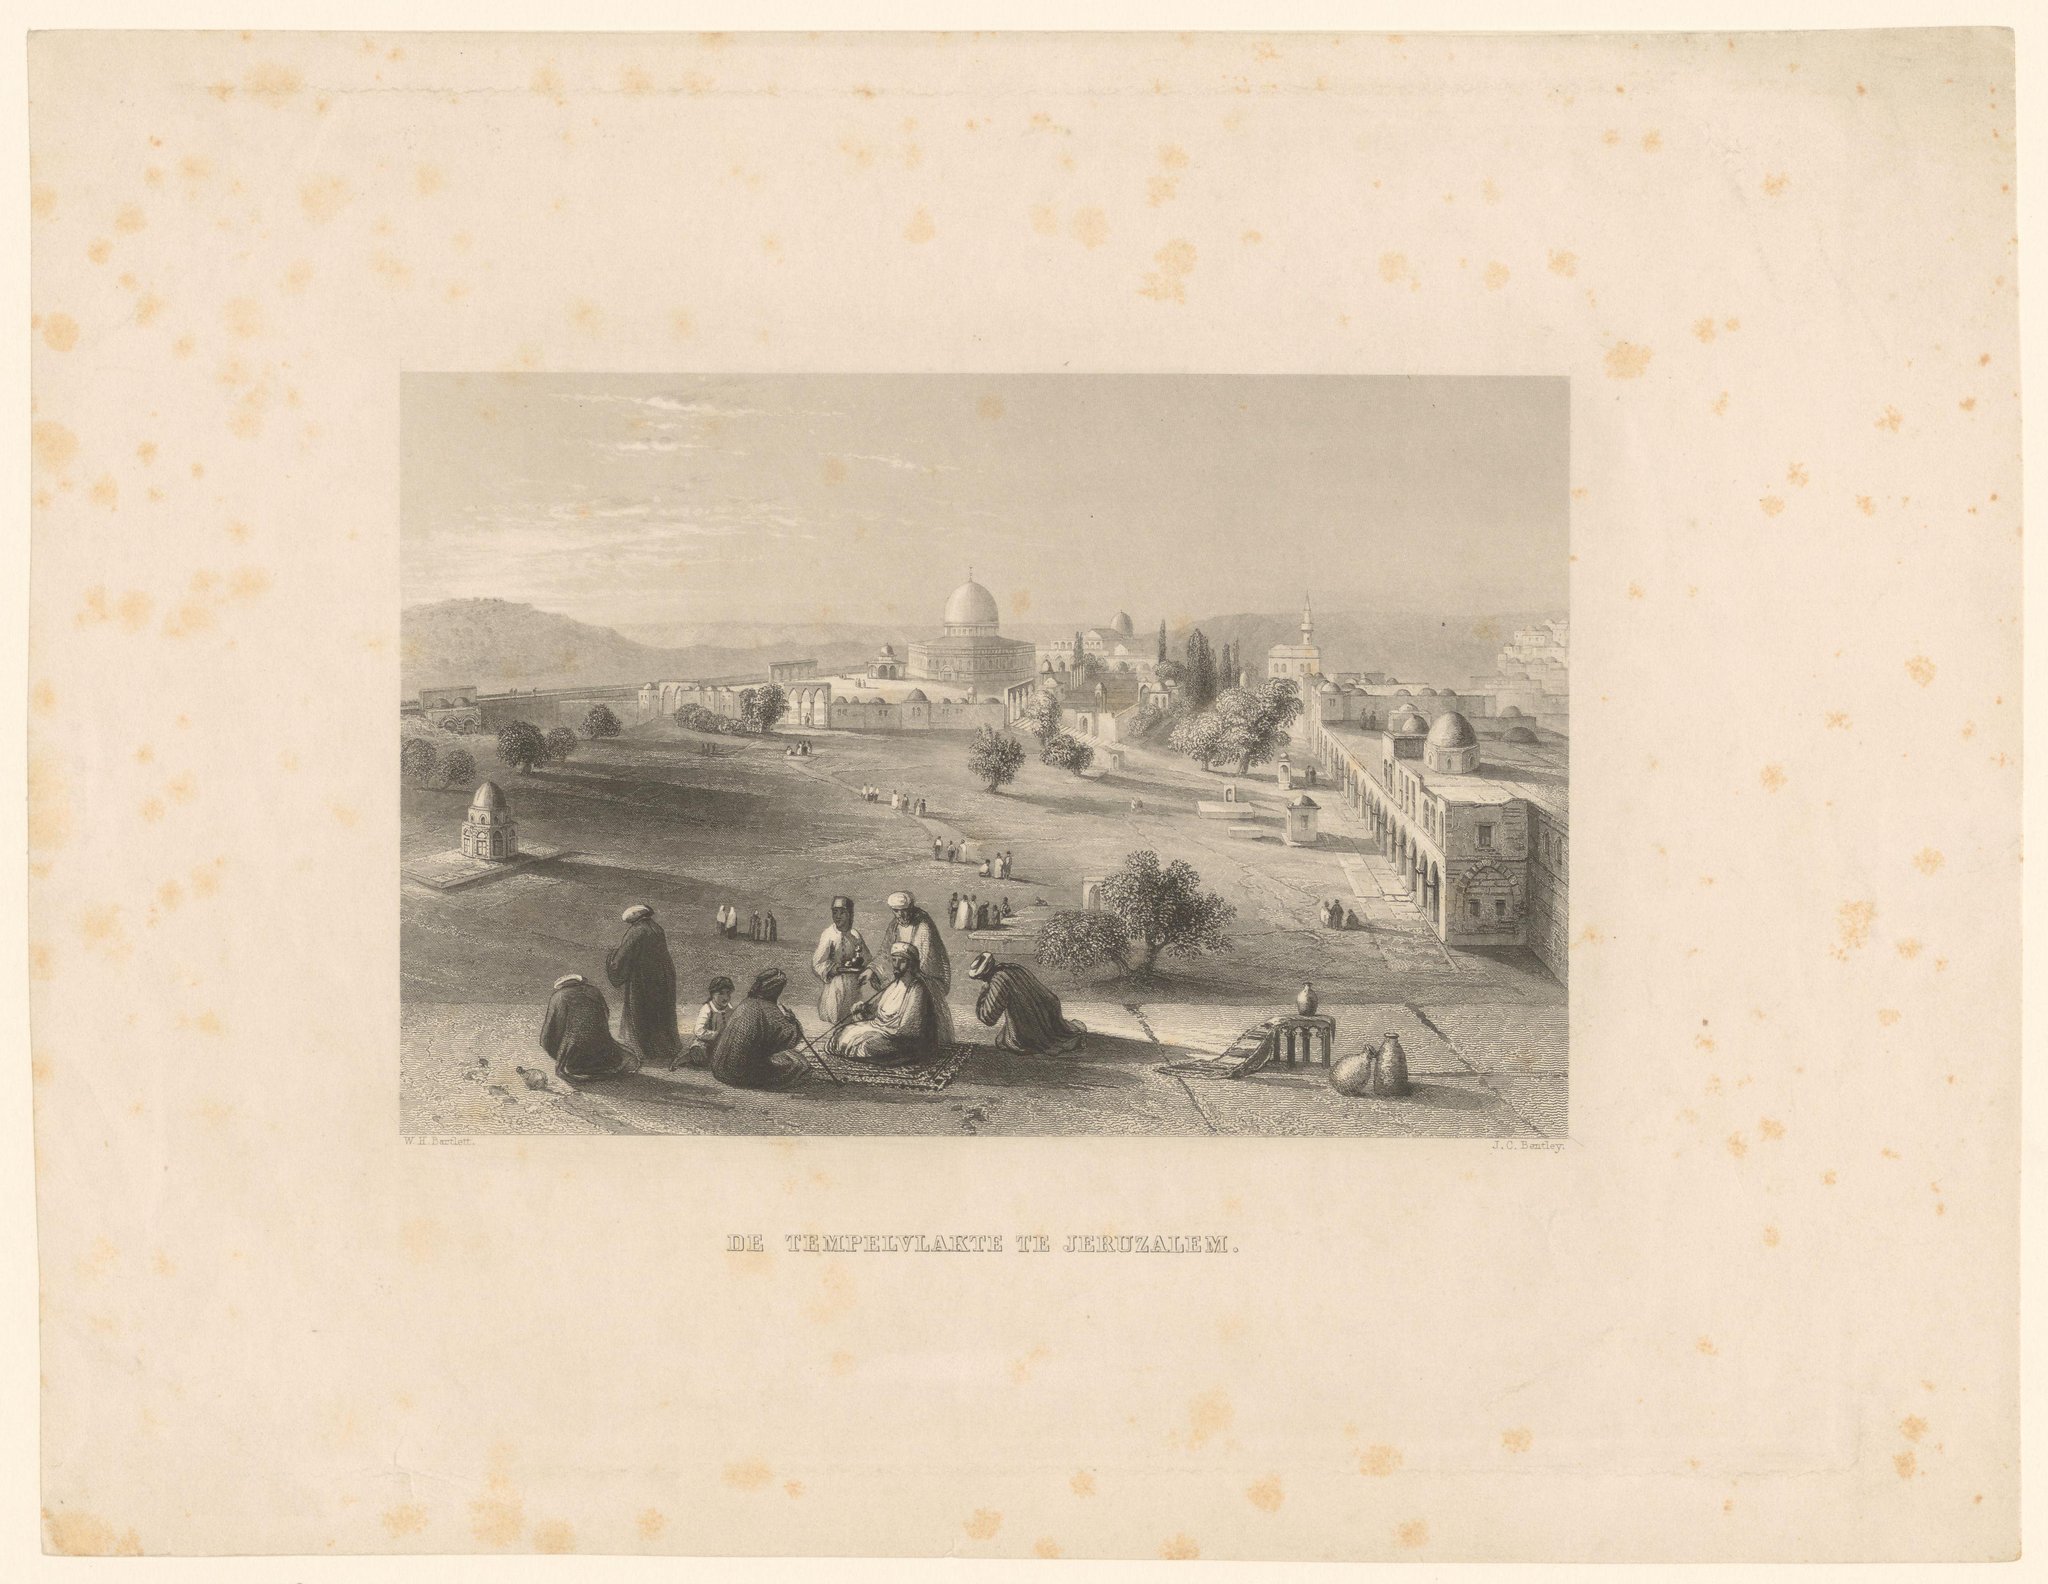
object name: print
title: De Tempelvlakte te Jeruzalem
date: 1846-1877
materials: paper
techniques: engraving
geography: gouda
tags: the temple (in general) ~ jewish religion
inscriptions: collector's mark: Lugt 2228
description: Prent in eerdere staat gebruikt in: Bartlett, William Henry. Walks about the City and Environs of Jerusalem. Londen: Virtue & Co, 1846.